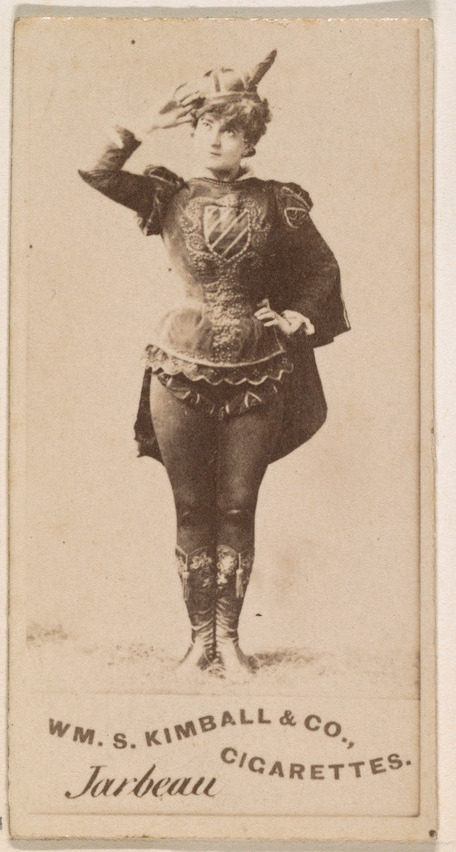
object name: photograph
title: Miss Jarbeau, from the Actresses series (N203) issued by Wm. S. Kimball & Co.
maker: william s. kimball & company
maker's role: publisher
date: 1889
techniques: color lithograph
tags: portraits,women,actresses